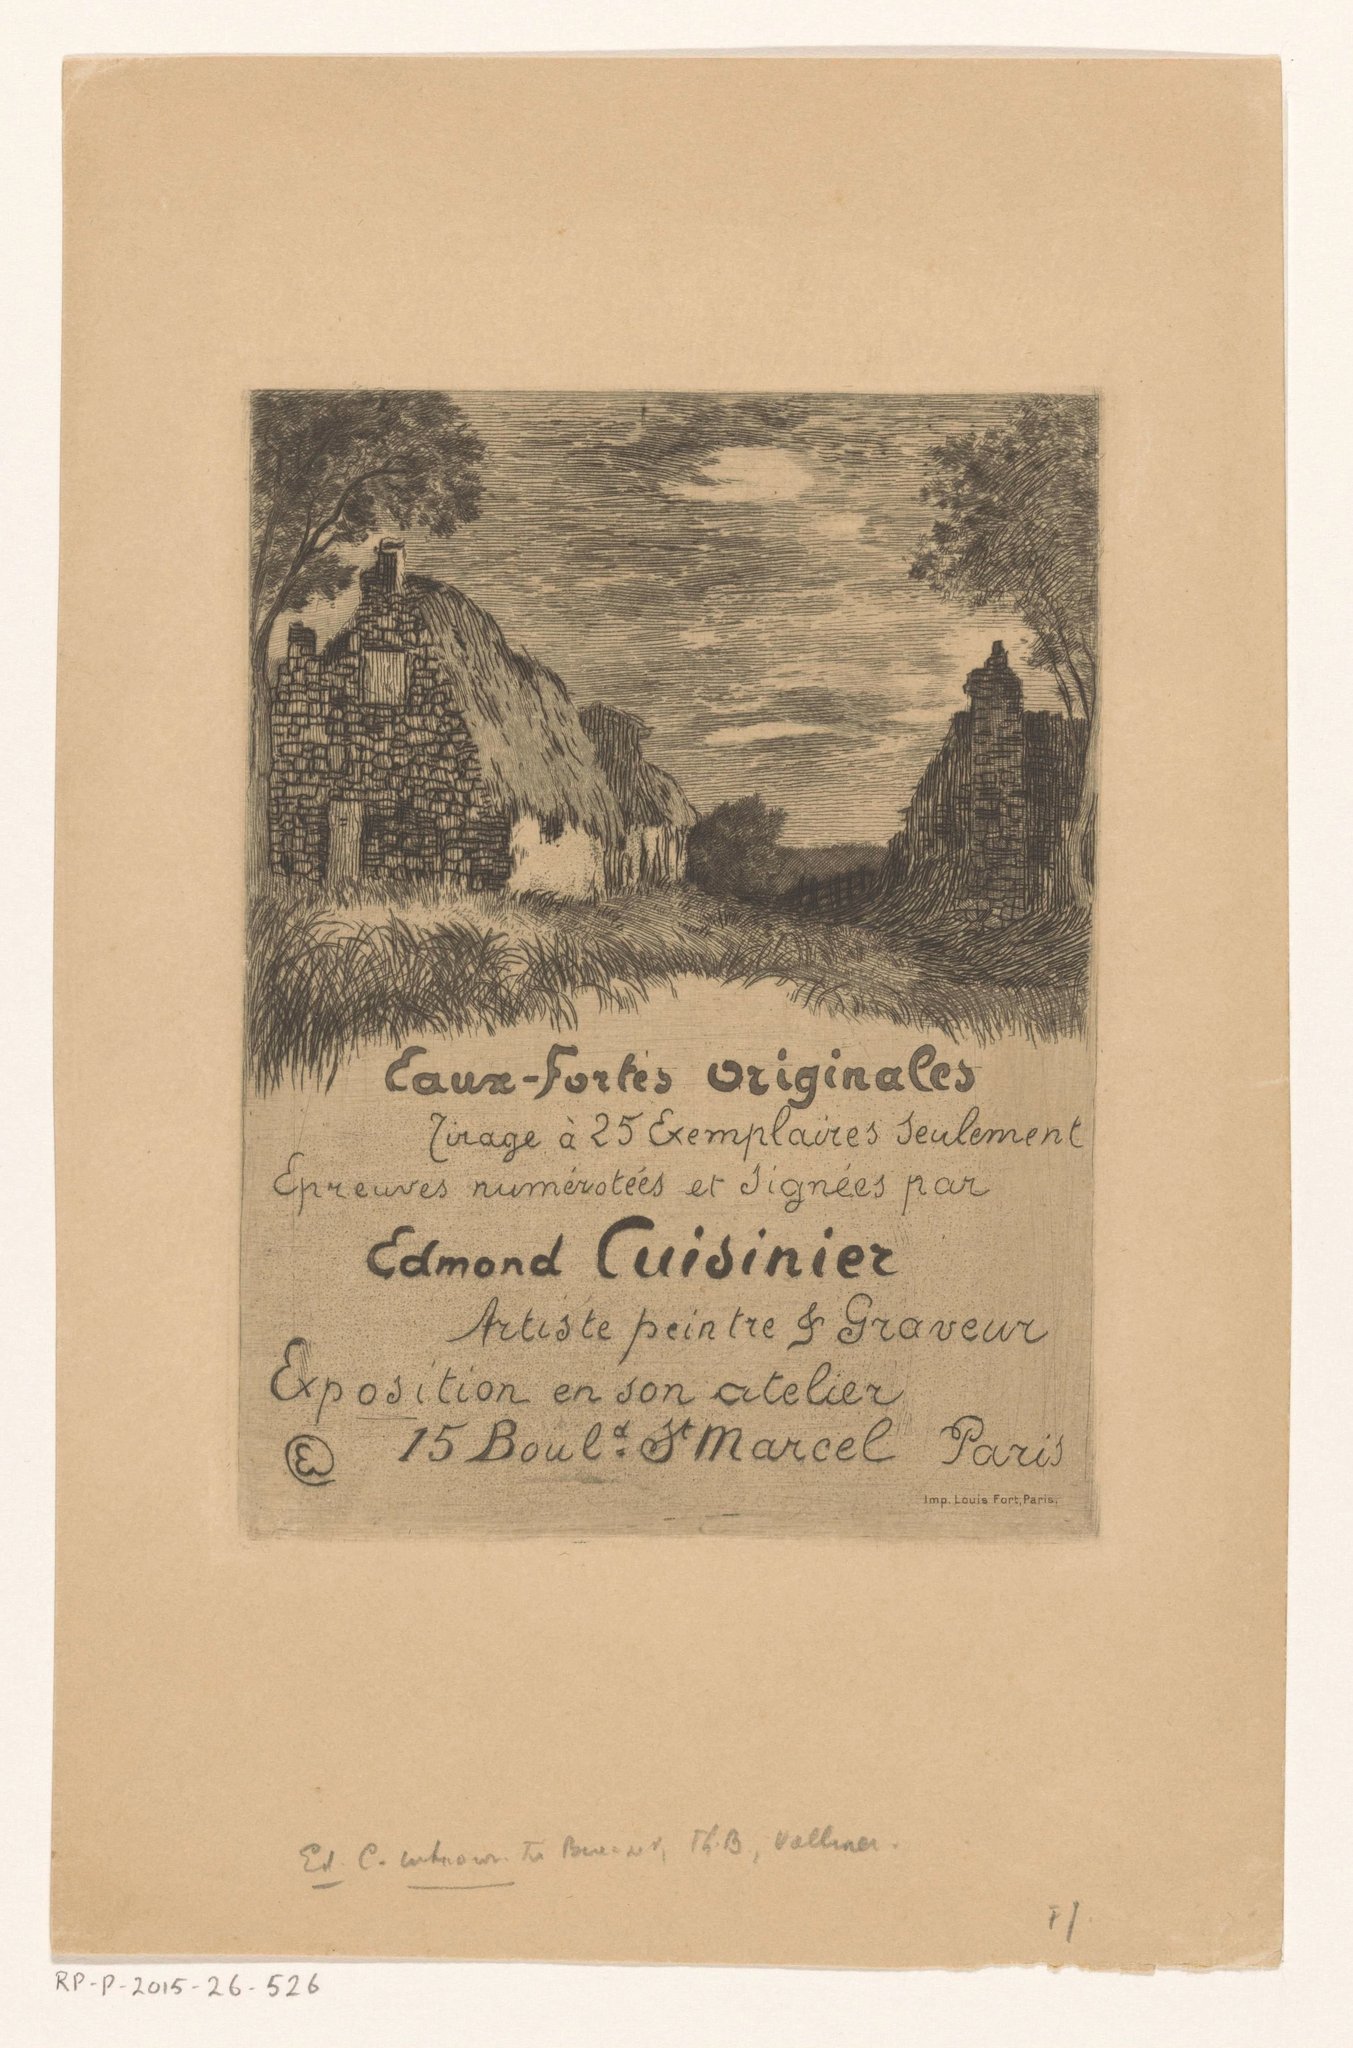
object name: visiting card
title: Visitekaartje van Edmond Cuisinier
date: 1867-1917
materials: paper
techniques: drypoint, etching, intaglio, soft ground etching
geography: paris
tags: landscapes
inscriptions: collector's mark: Lugt 2228, collector's mark: Lugt 4779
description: Op het kaartje kondigt de kunstenaar een tentoonstelling aan van zijn prentwerk, gehouden in zijn atelier.